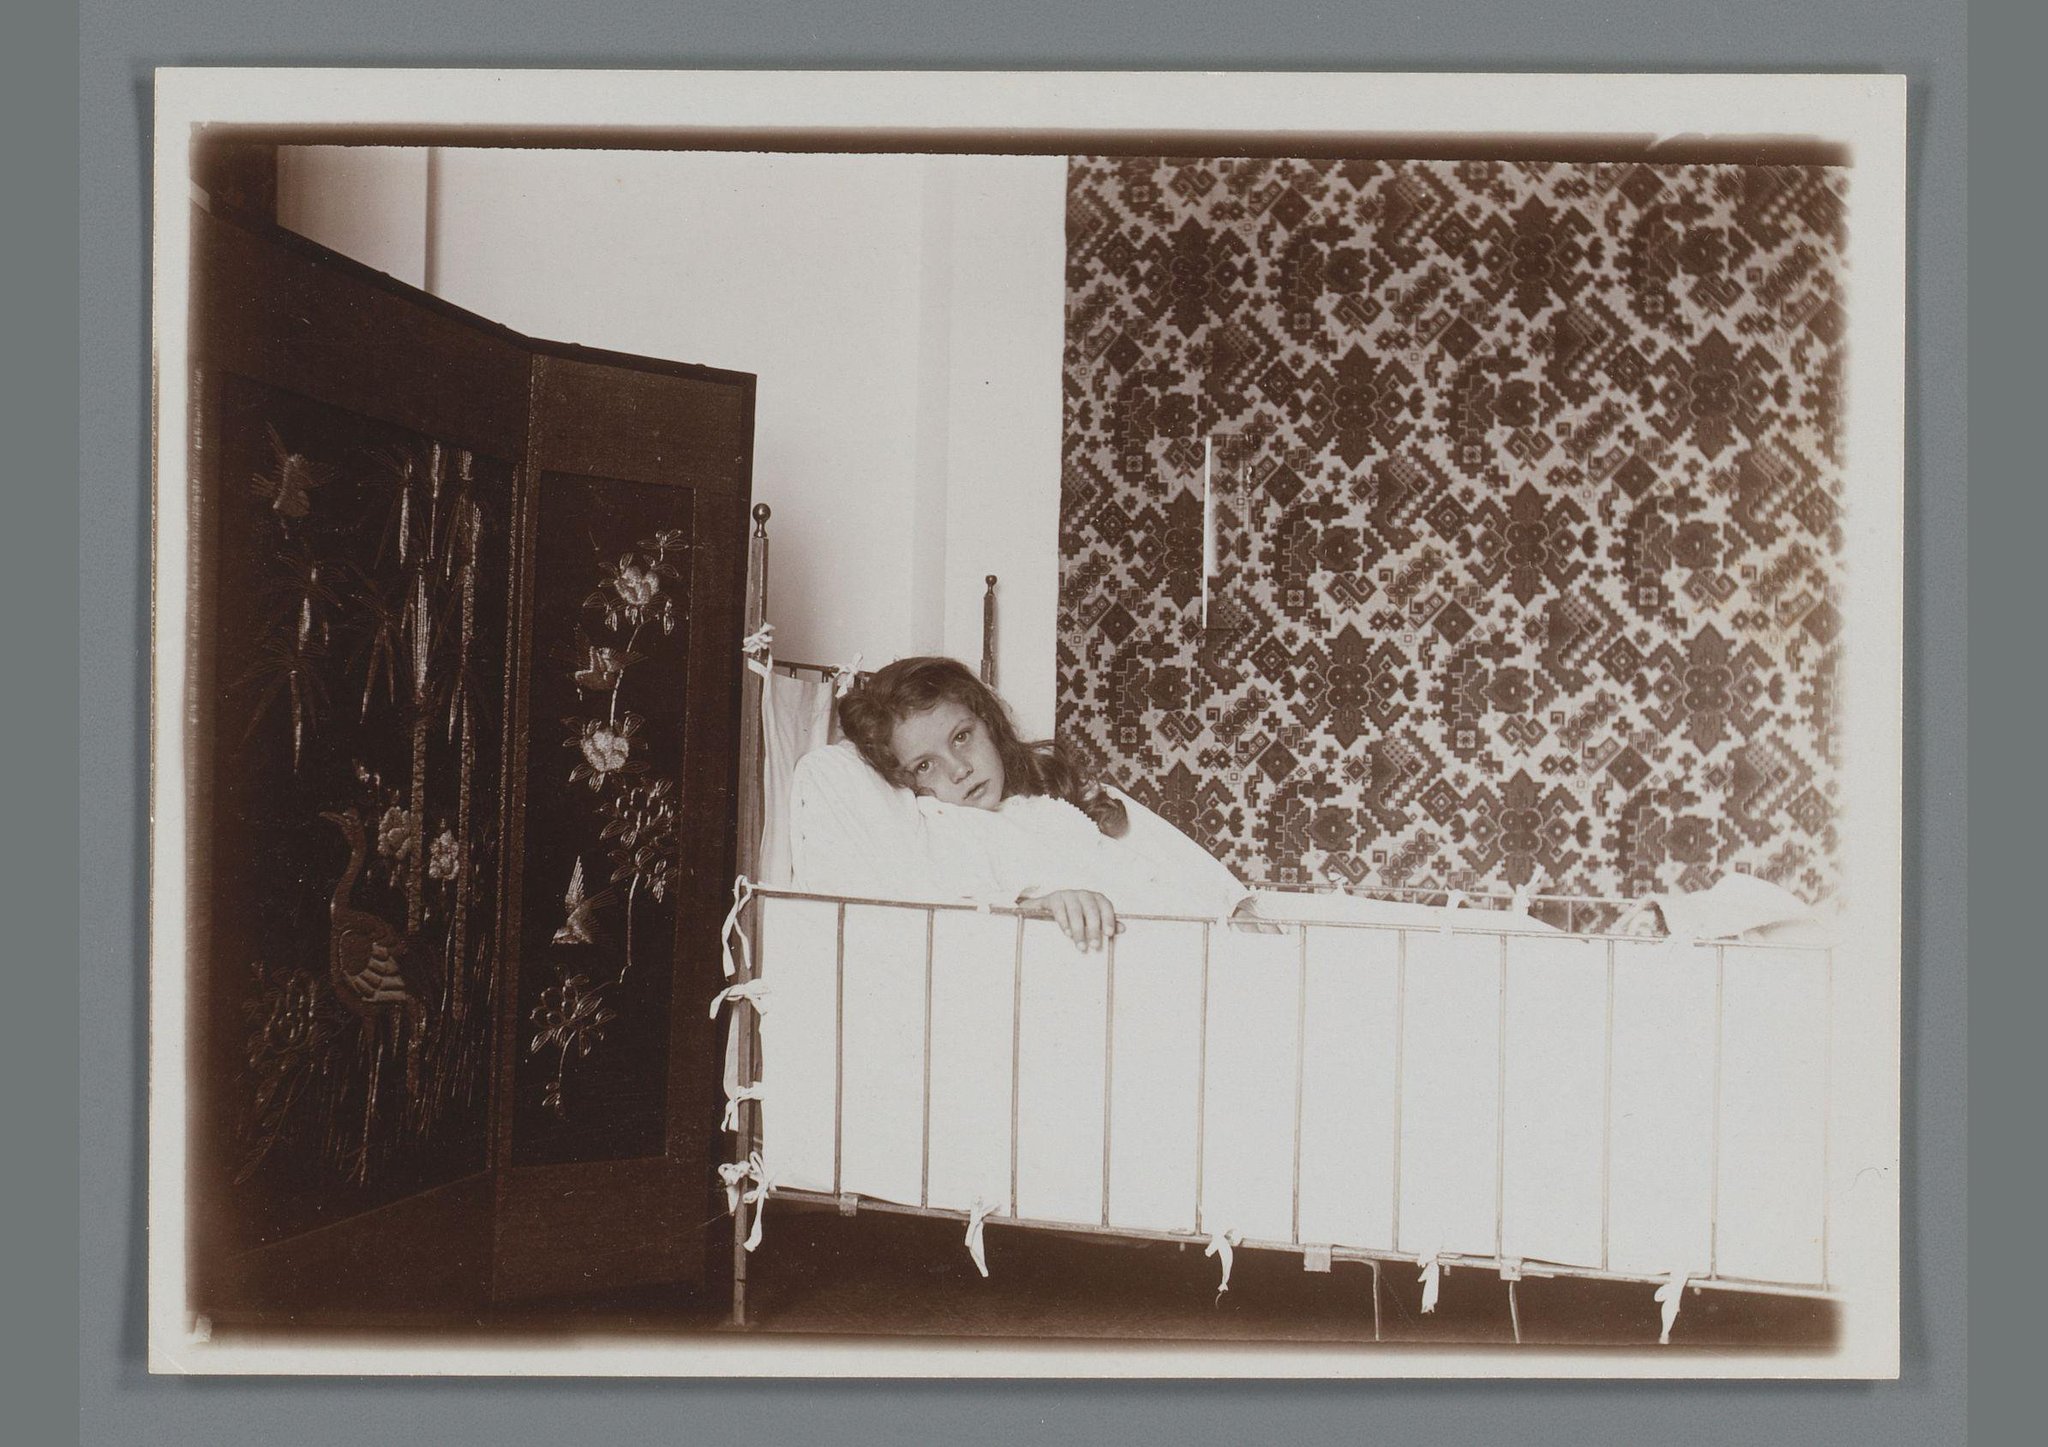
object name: photograph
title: Hansje, the Photographer’s Daughter, in Bed and at the Wash Basin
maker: willem de jong (fotograaf)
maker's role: arts, fotograaf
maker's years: 1864-1918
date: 1900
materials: paper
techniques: collodion silver print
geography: leiden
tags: johanna petronella lambertina stokhuyzen-de jong (hans), historical persons - bb - woman, girl (child between toddler and youth), bed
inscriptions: inscription: ‘H’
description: The most important achievement of late 19th-century amateur photography was the possibility it afforded of recording one’s personal life, wherein children and family took centre stage. Here the Leiden physician Willem de Jong photographed his young daughter Hansje. The doctor was a doting father to his only child, and always had his camera at the ready at home and on holidays.